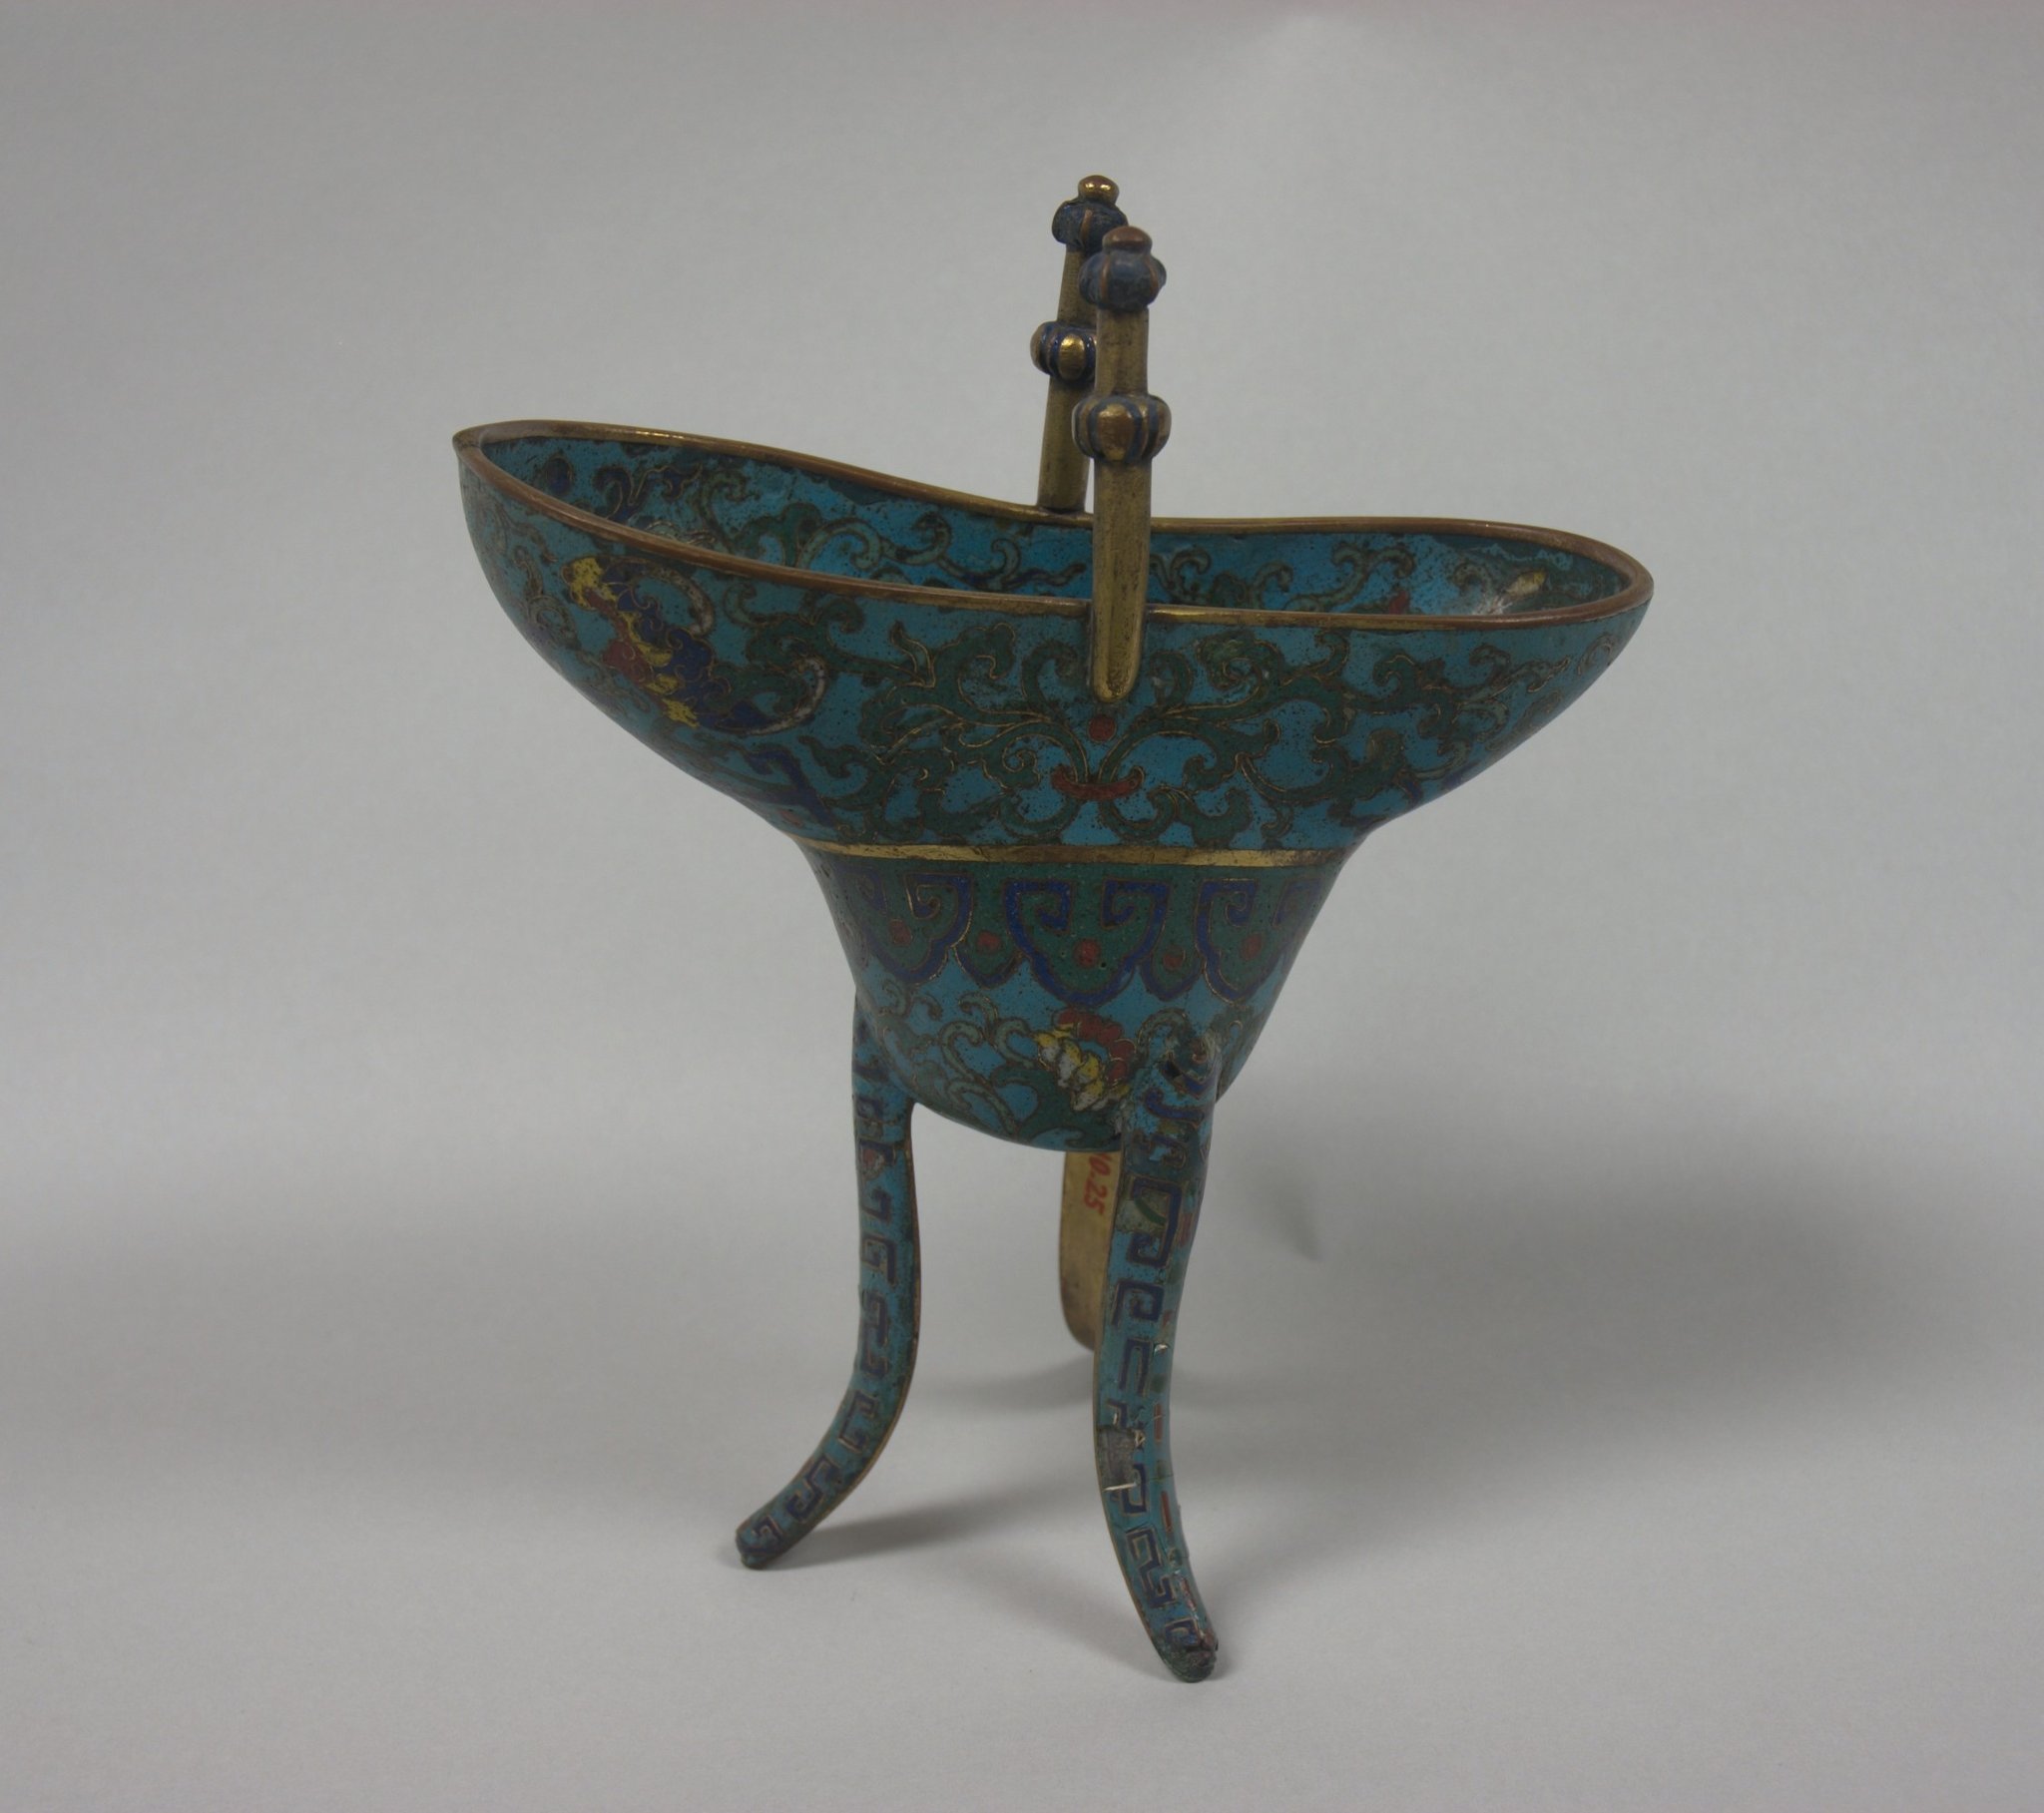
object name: vessel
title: Sacrificial Vessel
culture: chinese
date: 1368-1644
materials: enamel, copper gilt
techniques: enamel